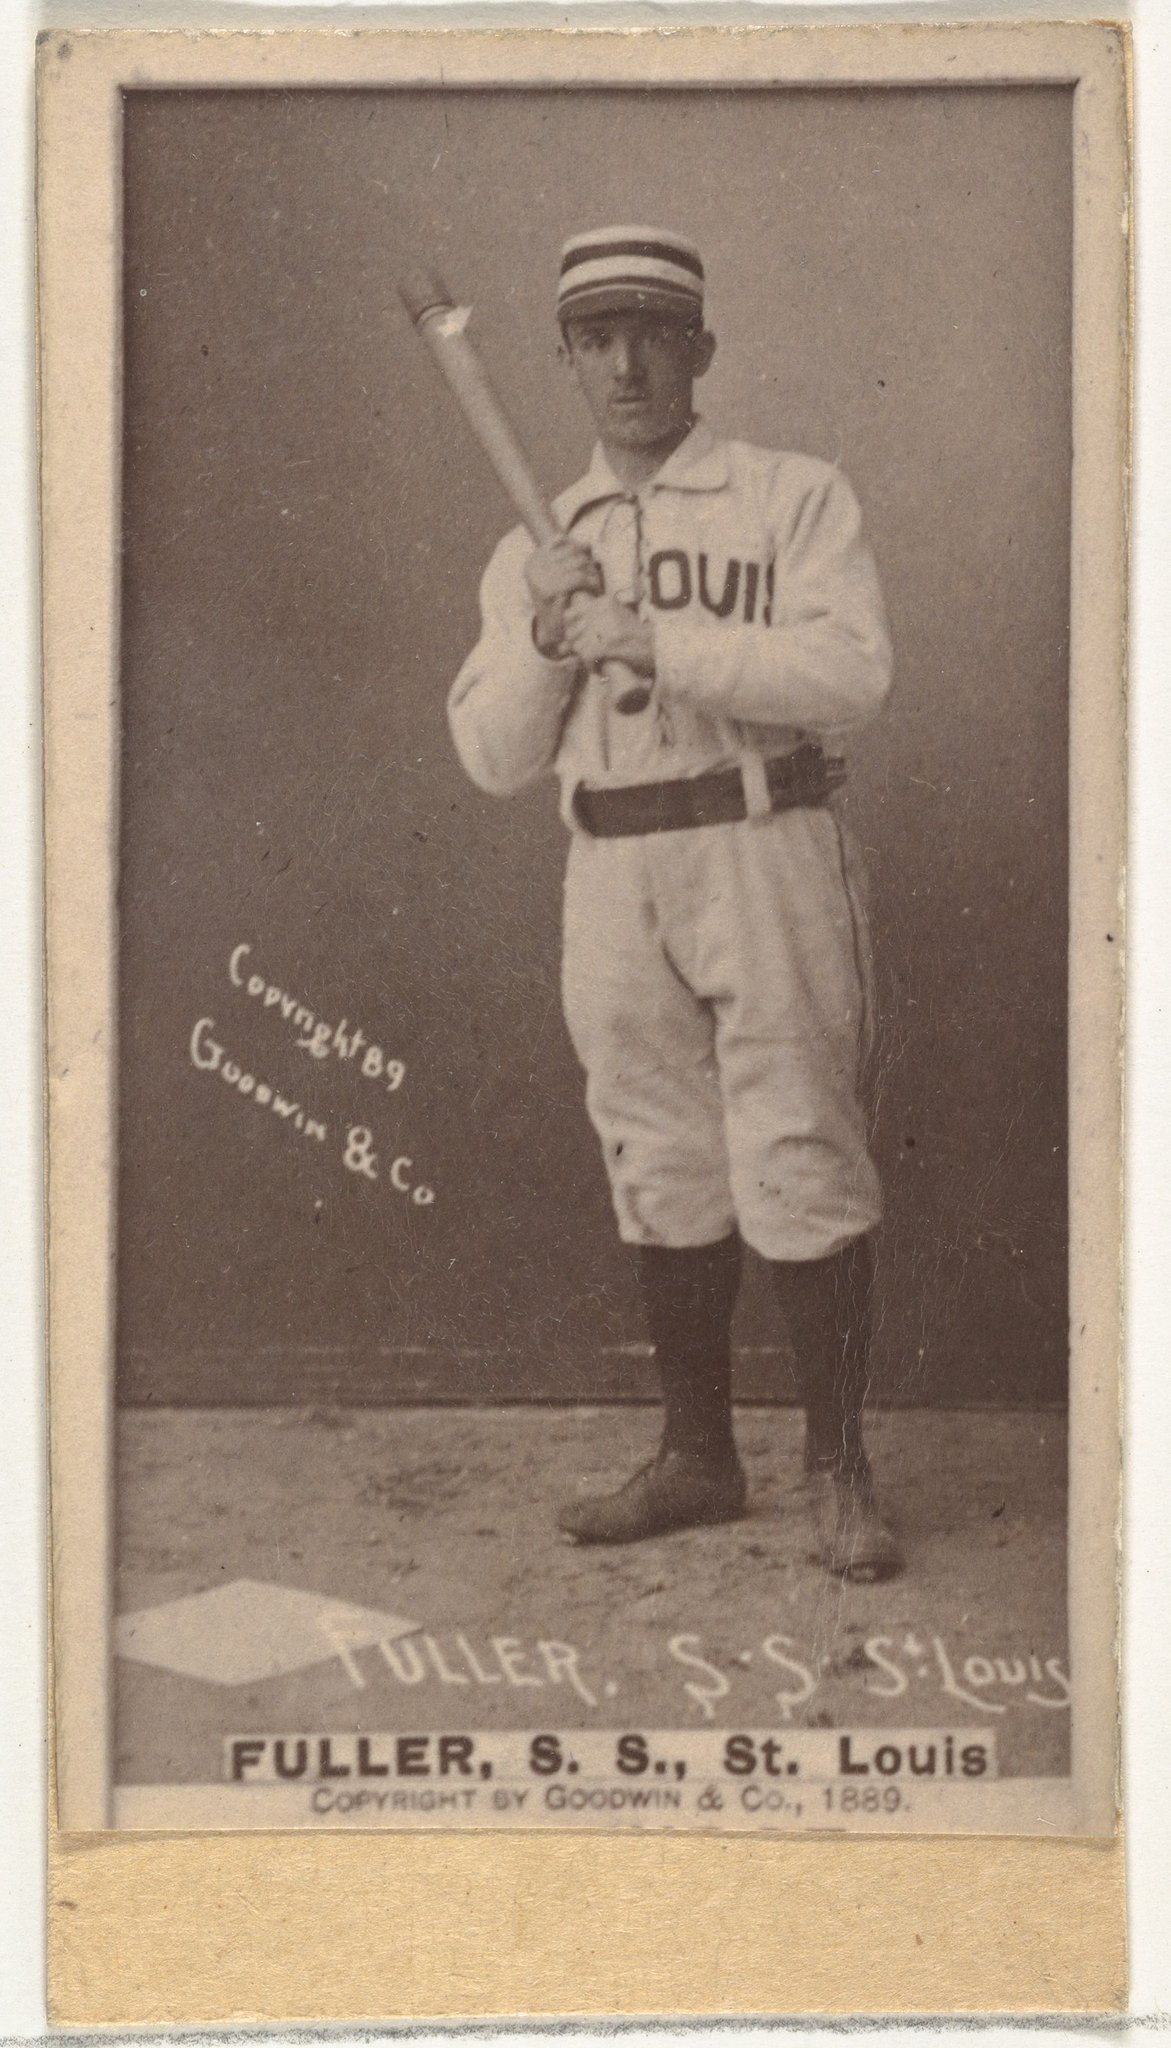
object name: baseball card, photograph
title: William Benjamin "Shorty" Fuller, Shortstop, St. Louis Browns, from the Old Judge series (N172) for Old Judge Cigarettes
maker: goodwin & company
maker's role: publisher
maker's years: 1850-1950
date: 1889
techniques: albumen silver print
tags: men,portraits,baseball,athletes